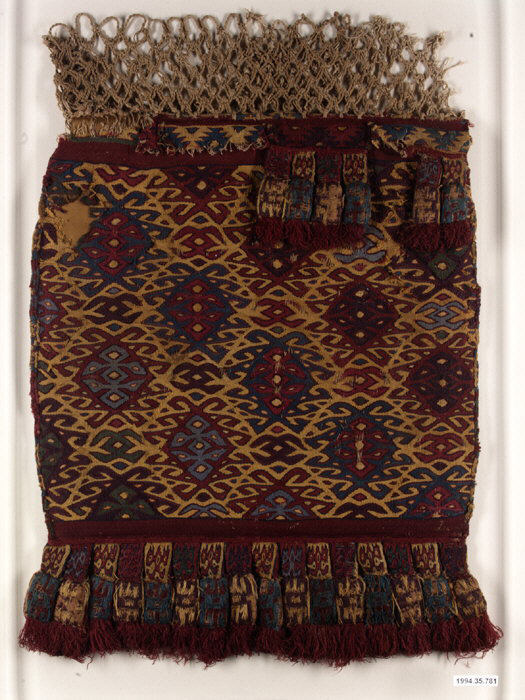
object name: bag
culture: peruvian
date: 1301-1600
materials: animal fiber, cotton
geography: peru